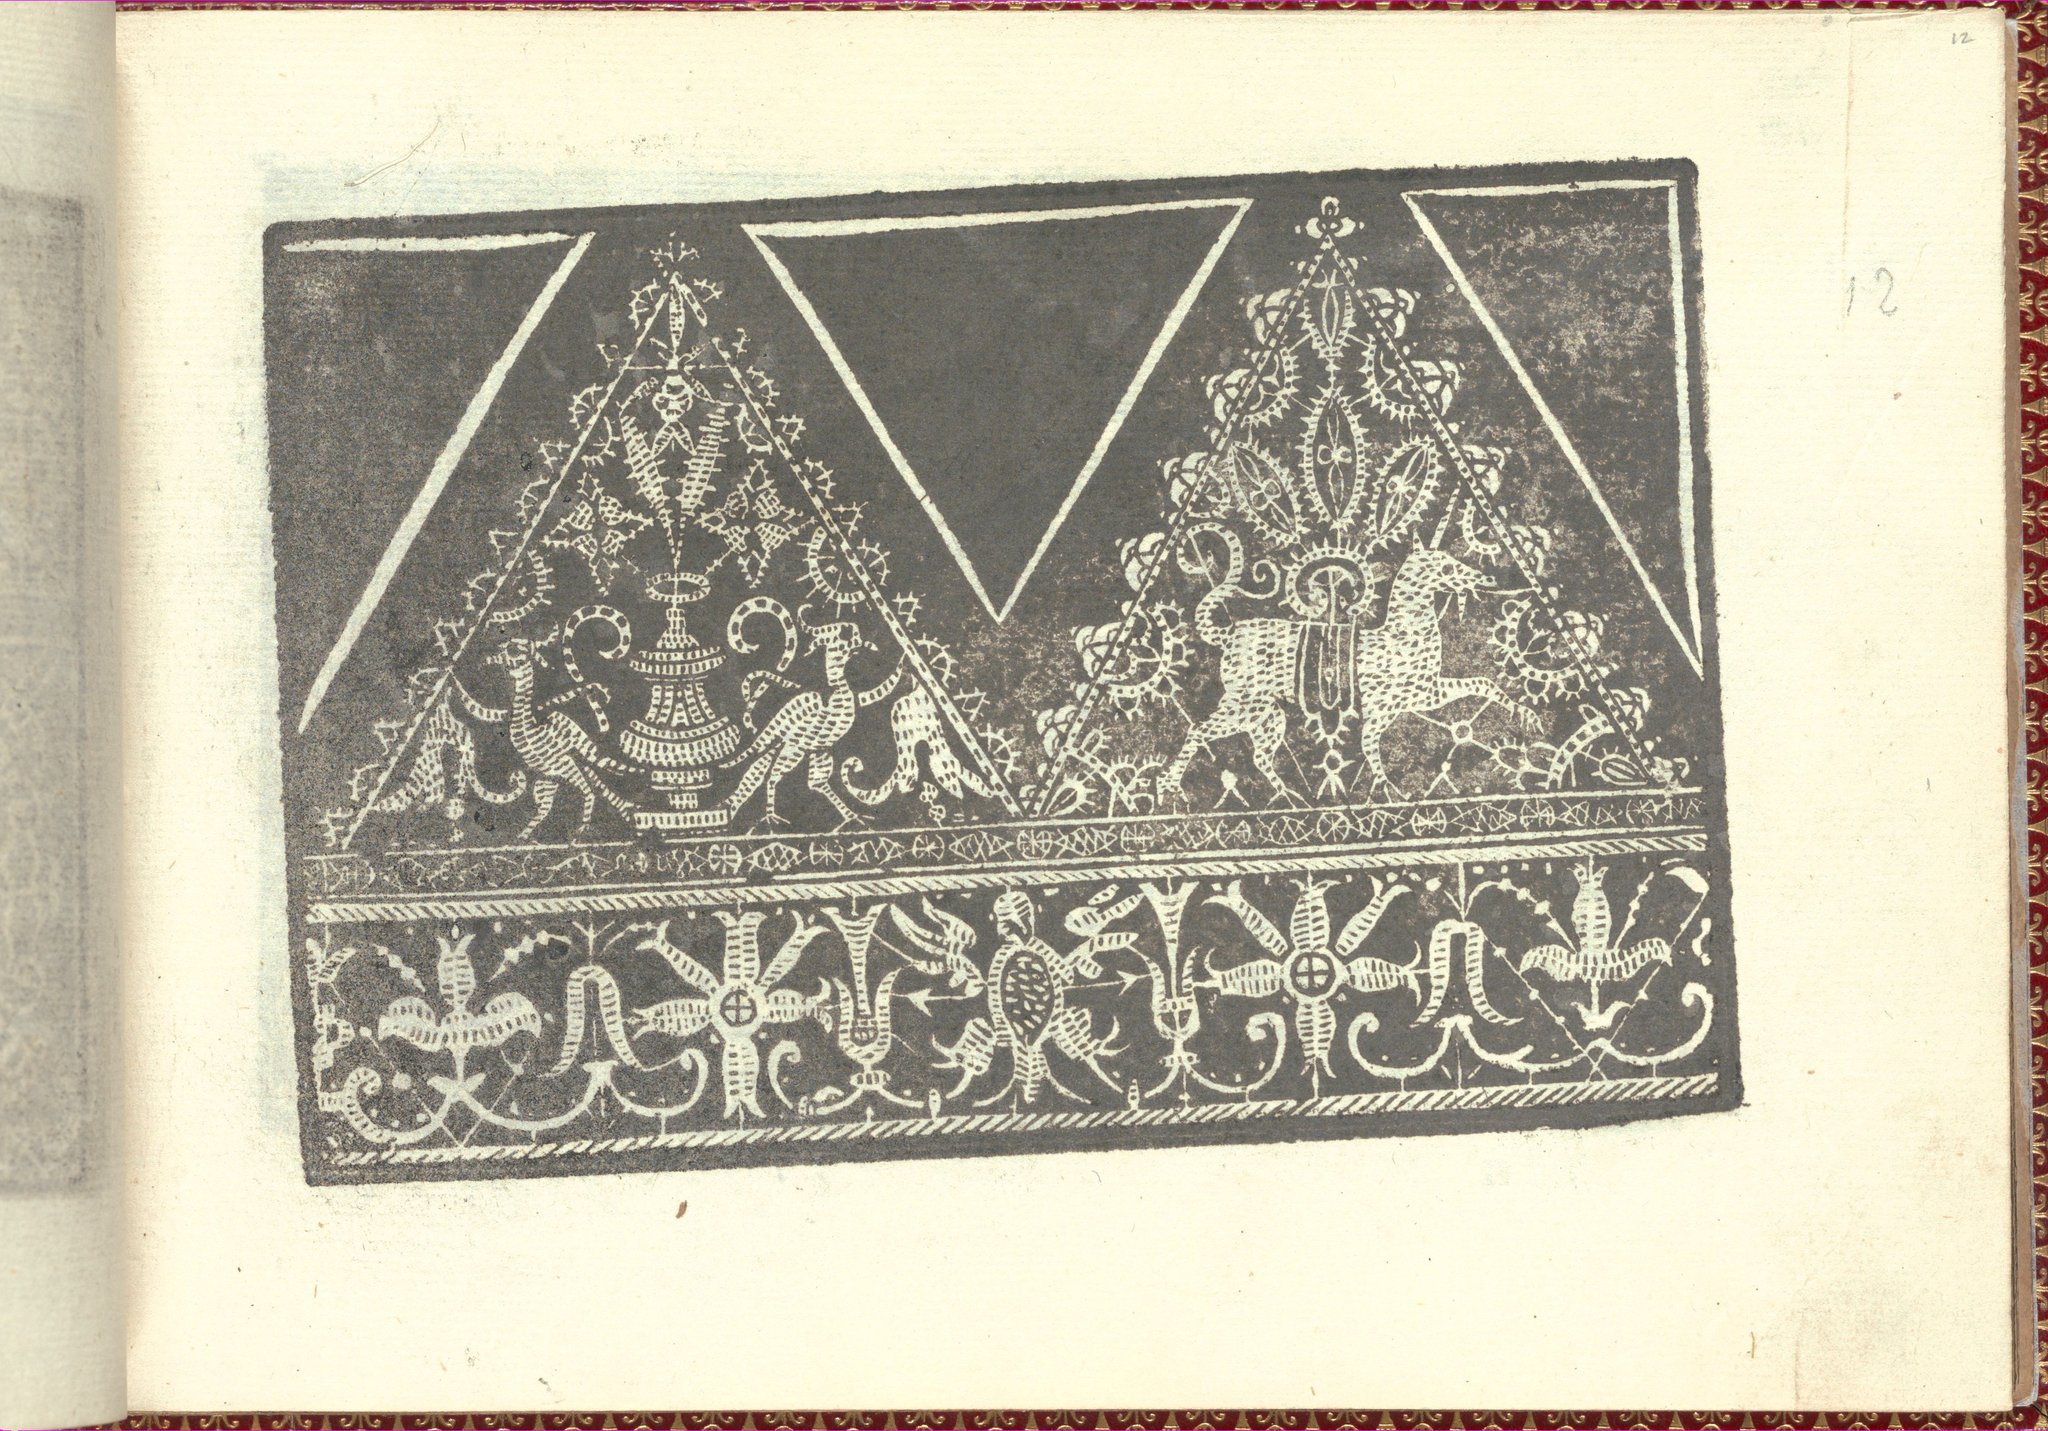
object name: book print ornament architecture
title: Corona delle Nobili et Virtuose Donne: Libro I-IV, page 12 (recto)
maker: cesare vecellio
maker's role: publisher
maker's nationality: italian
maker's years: 1521-1601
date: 1601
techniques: woodcut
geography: italy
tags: birds,ornament,unicorns